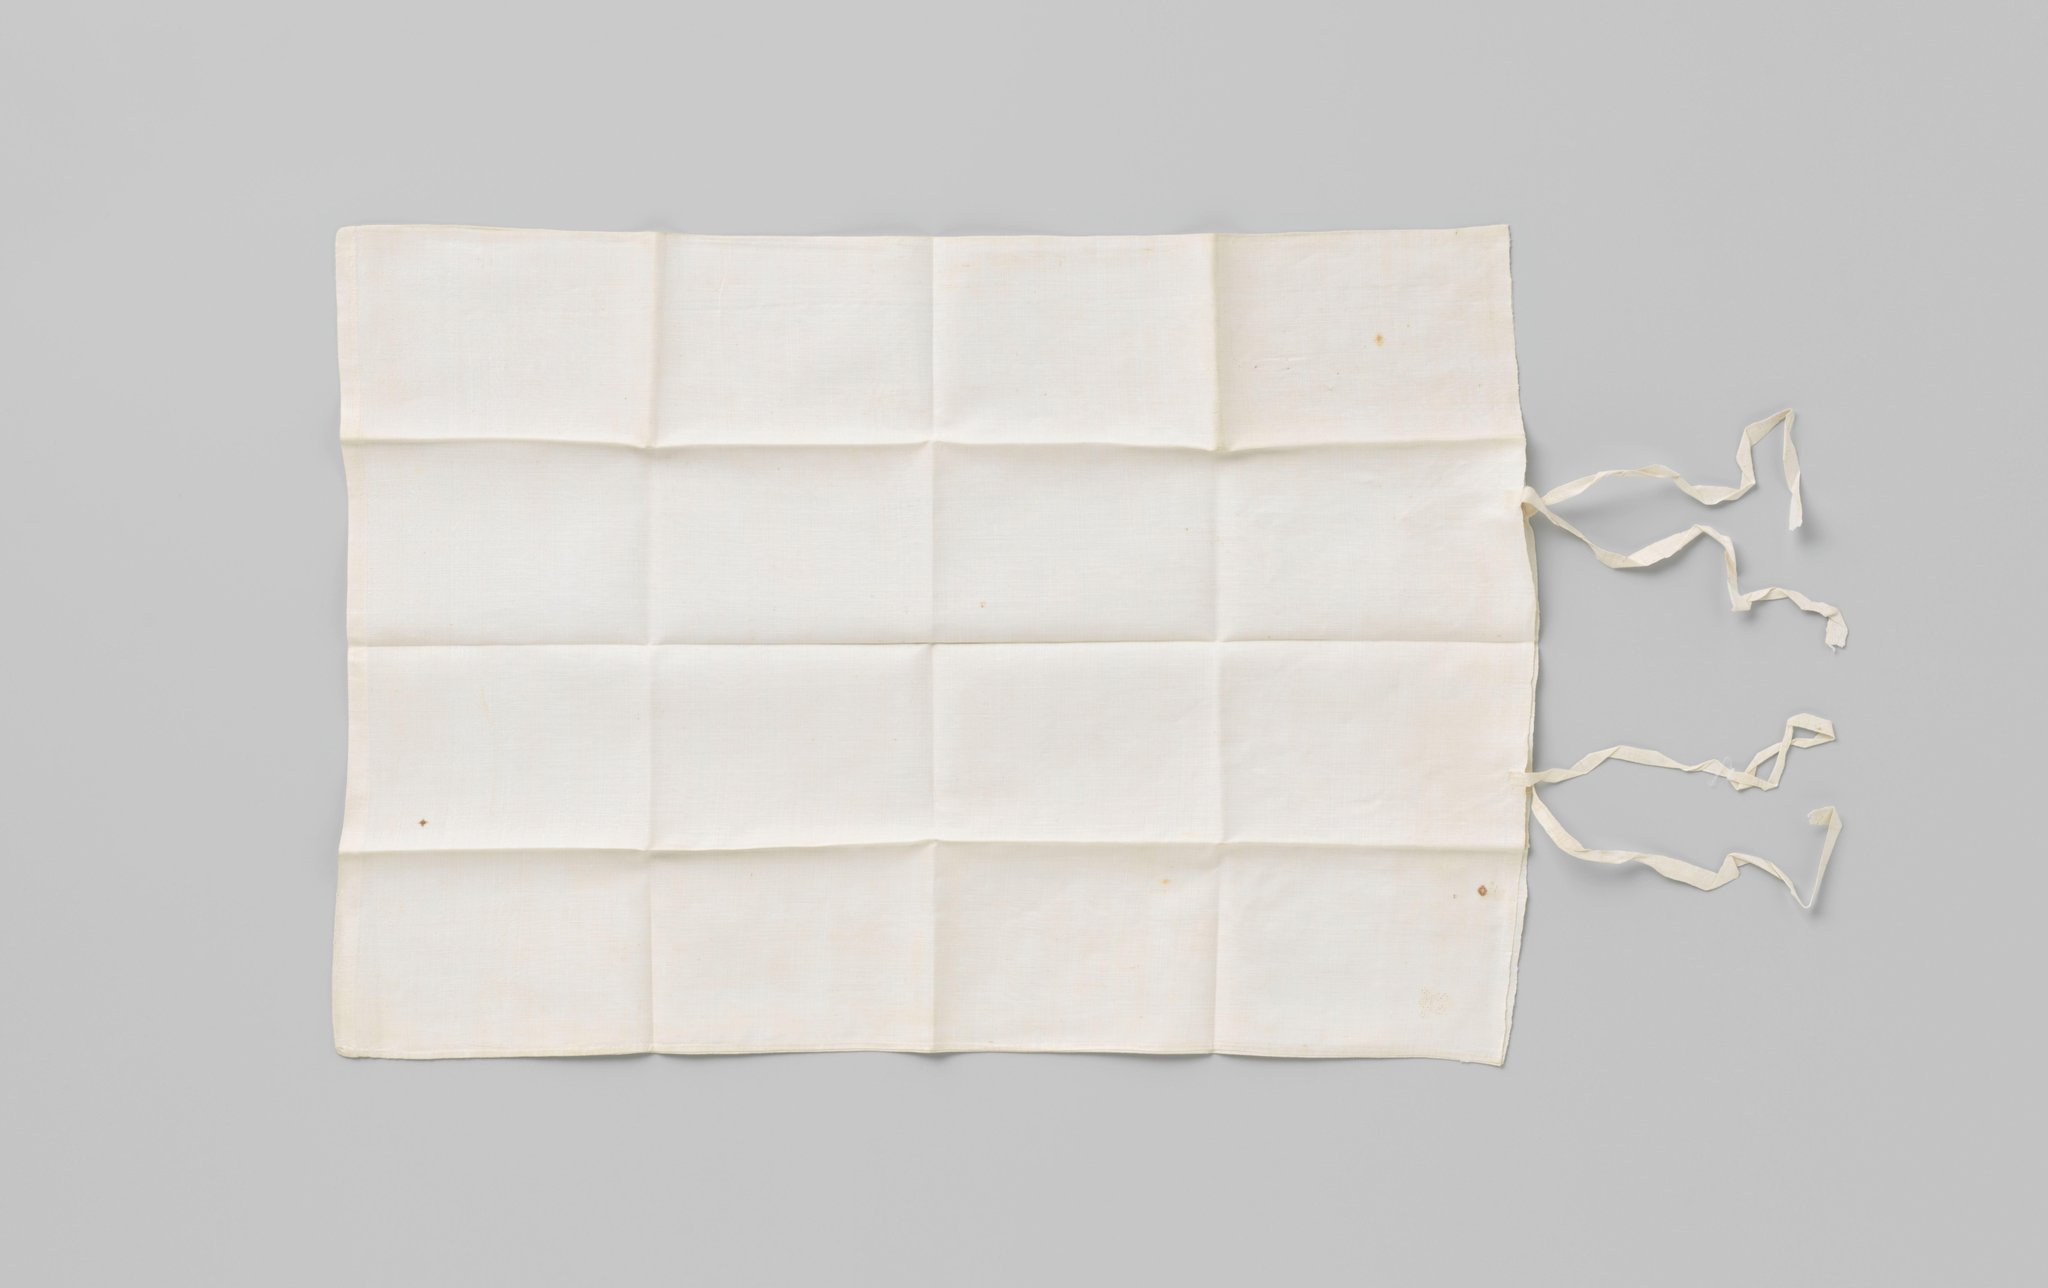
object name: lendensloop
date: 1692-1735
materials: linen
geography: northern netherlands